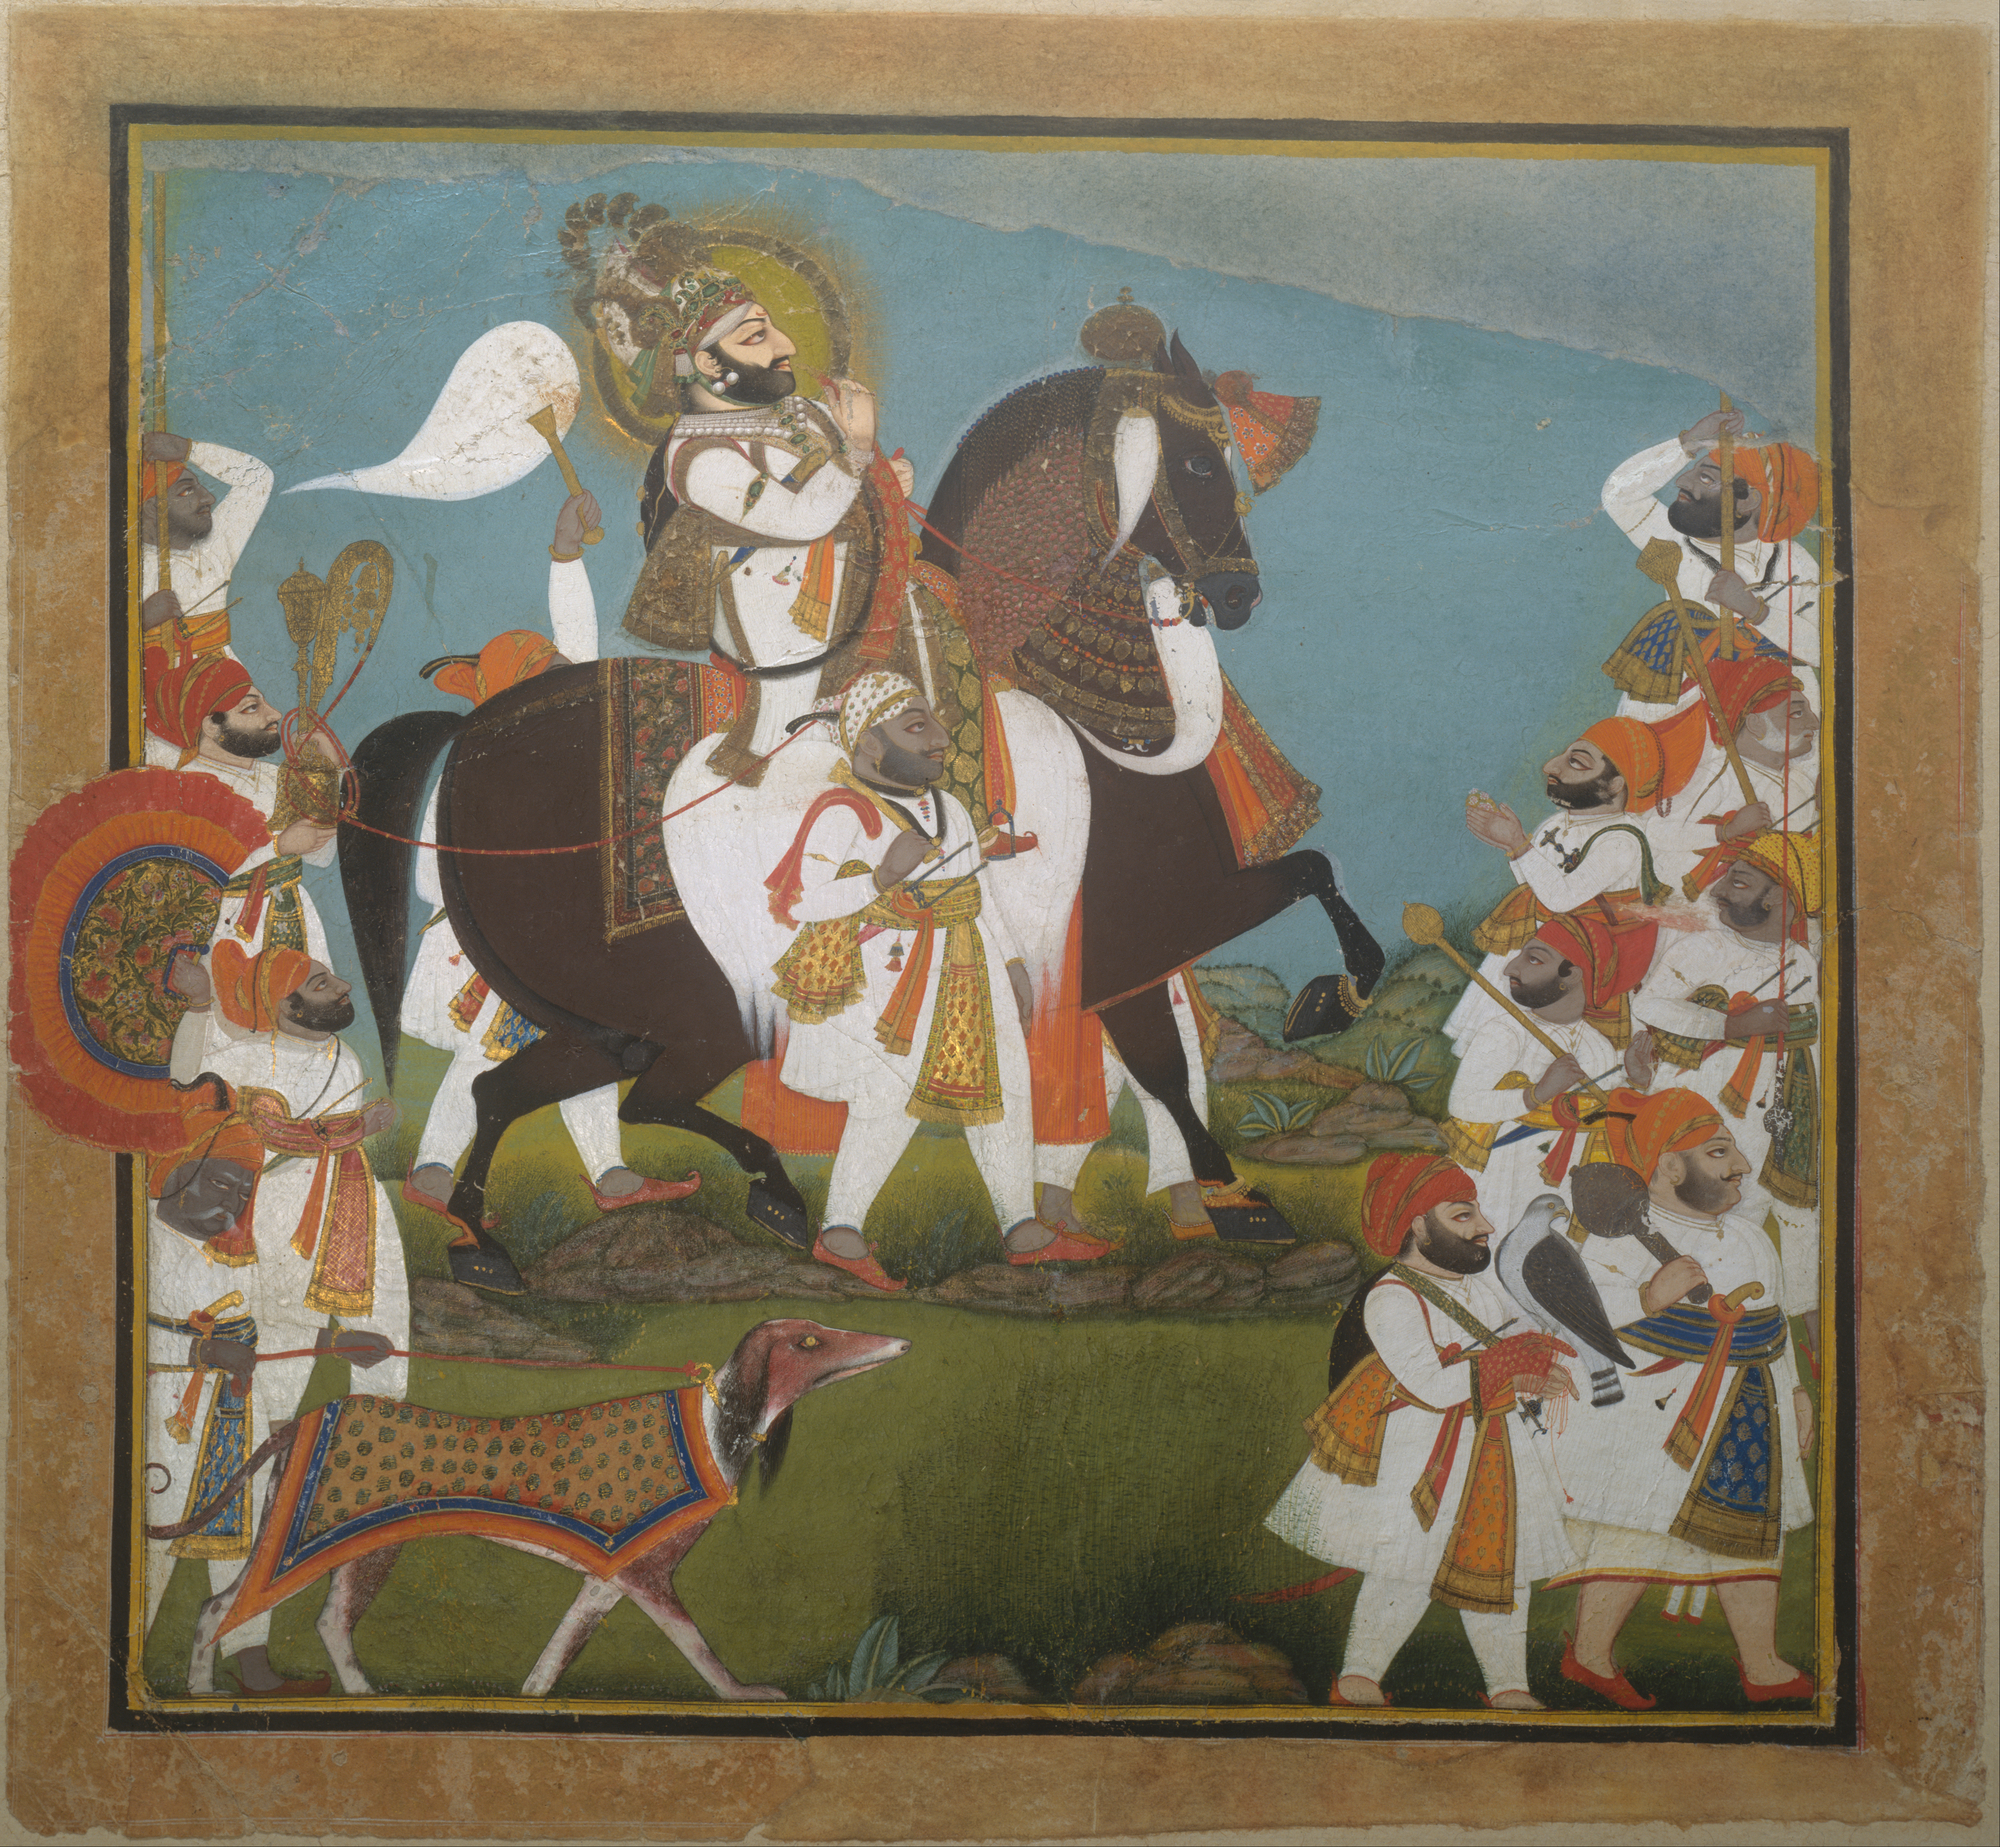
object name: painting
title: Maharana Bhim Singh and Retinue Embark on a Hunt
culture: western indian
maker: chokha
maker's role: artist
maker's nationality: indian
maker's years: 1799-1826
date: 1805-1810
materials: gold, ink, paper, watercolor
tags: falcons,men,hunting,dogs,horses,hookah